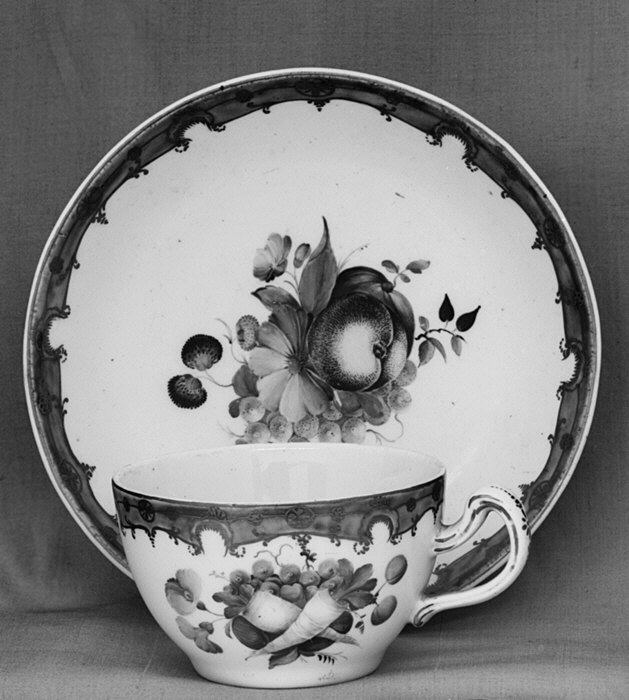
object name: cup and saucer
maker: the hague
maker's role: factory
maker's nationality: dutch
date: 1785-1790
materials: hard paste porcelain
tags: fruit,vegetables,flowers